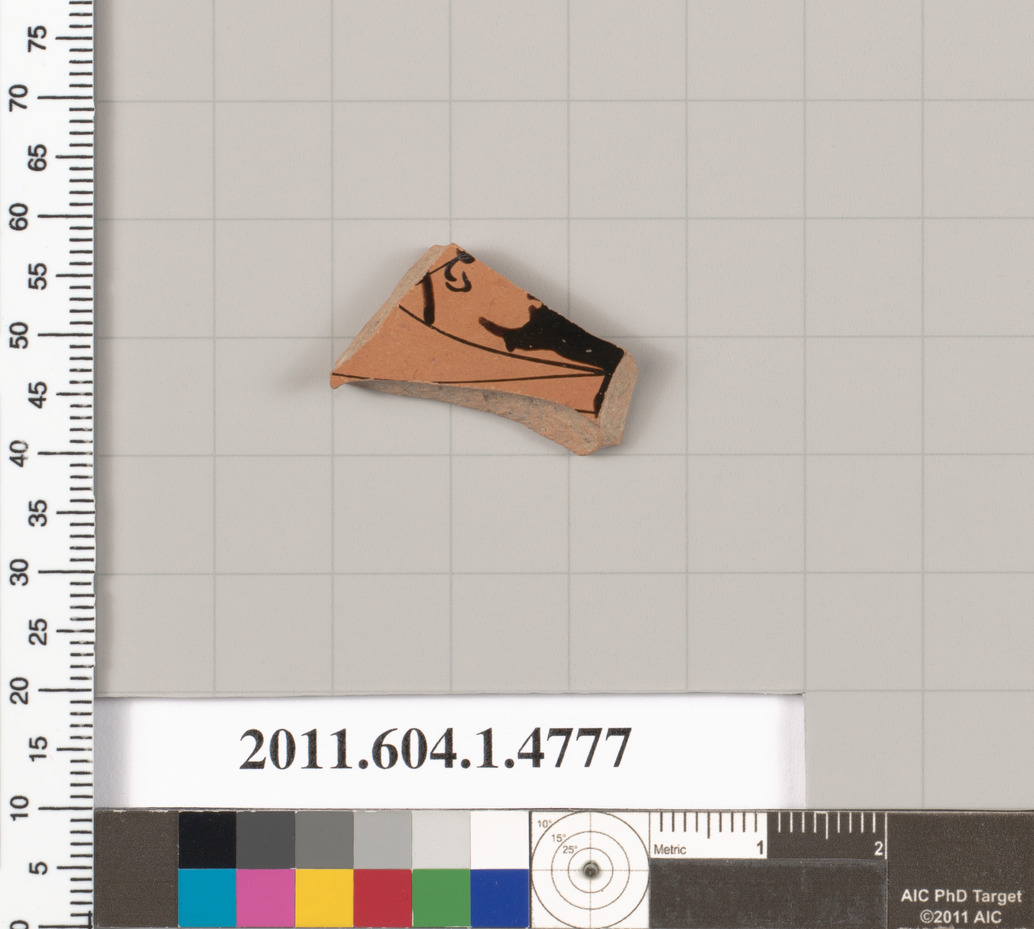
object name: kylix fragment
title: Terracotta fragment of a kylix (drinking cup)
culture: greek, attic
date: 475-451 BCE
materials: terracotta